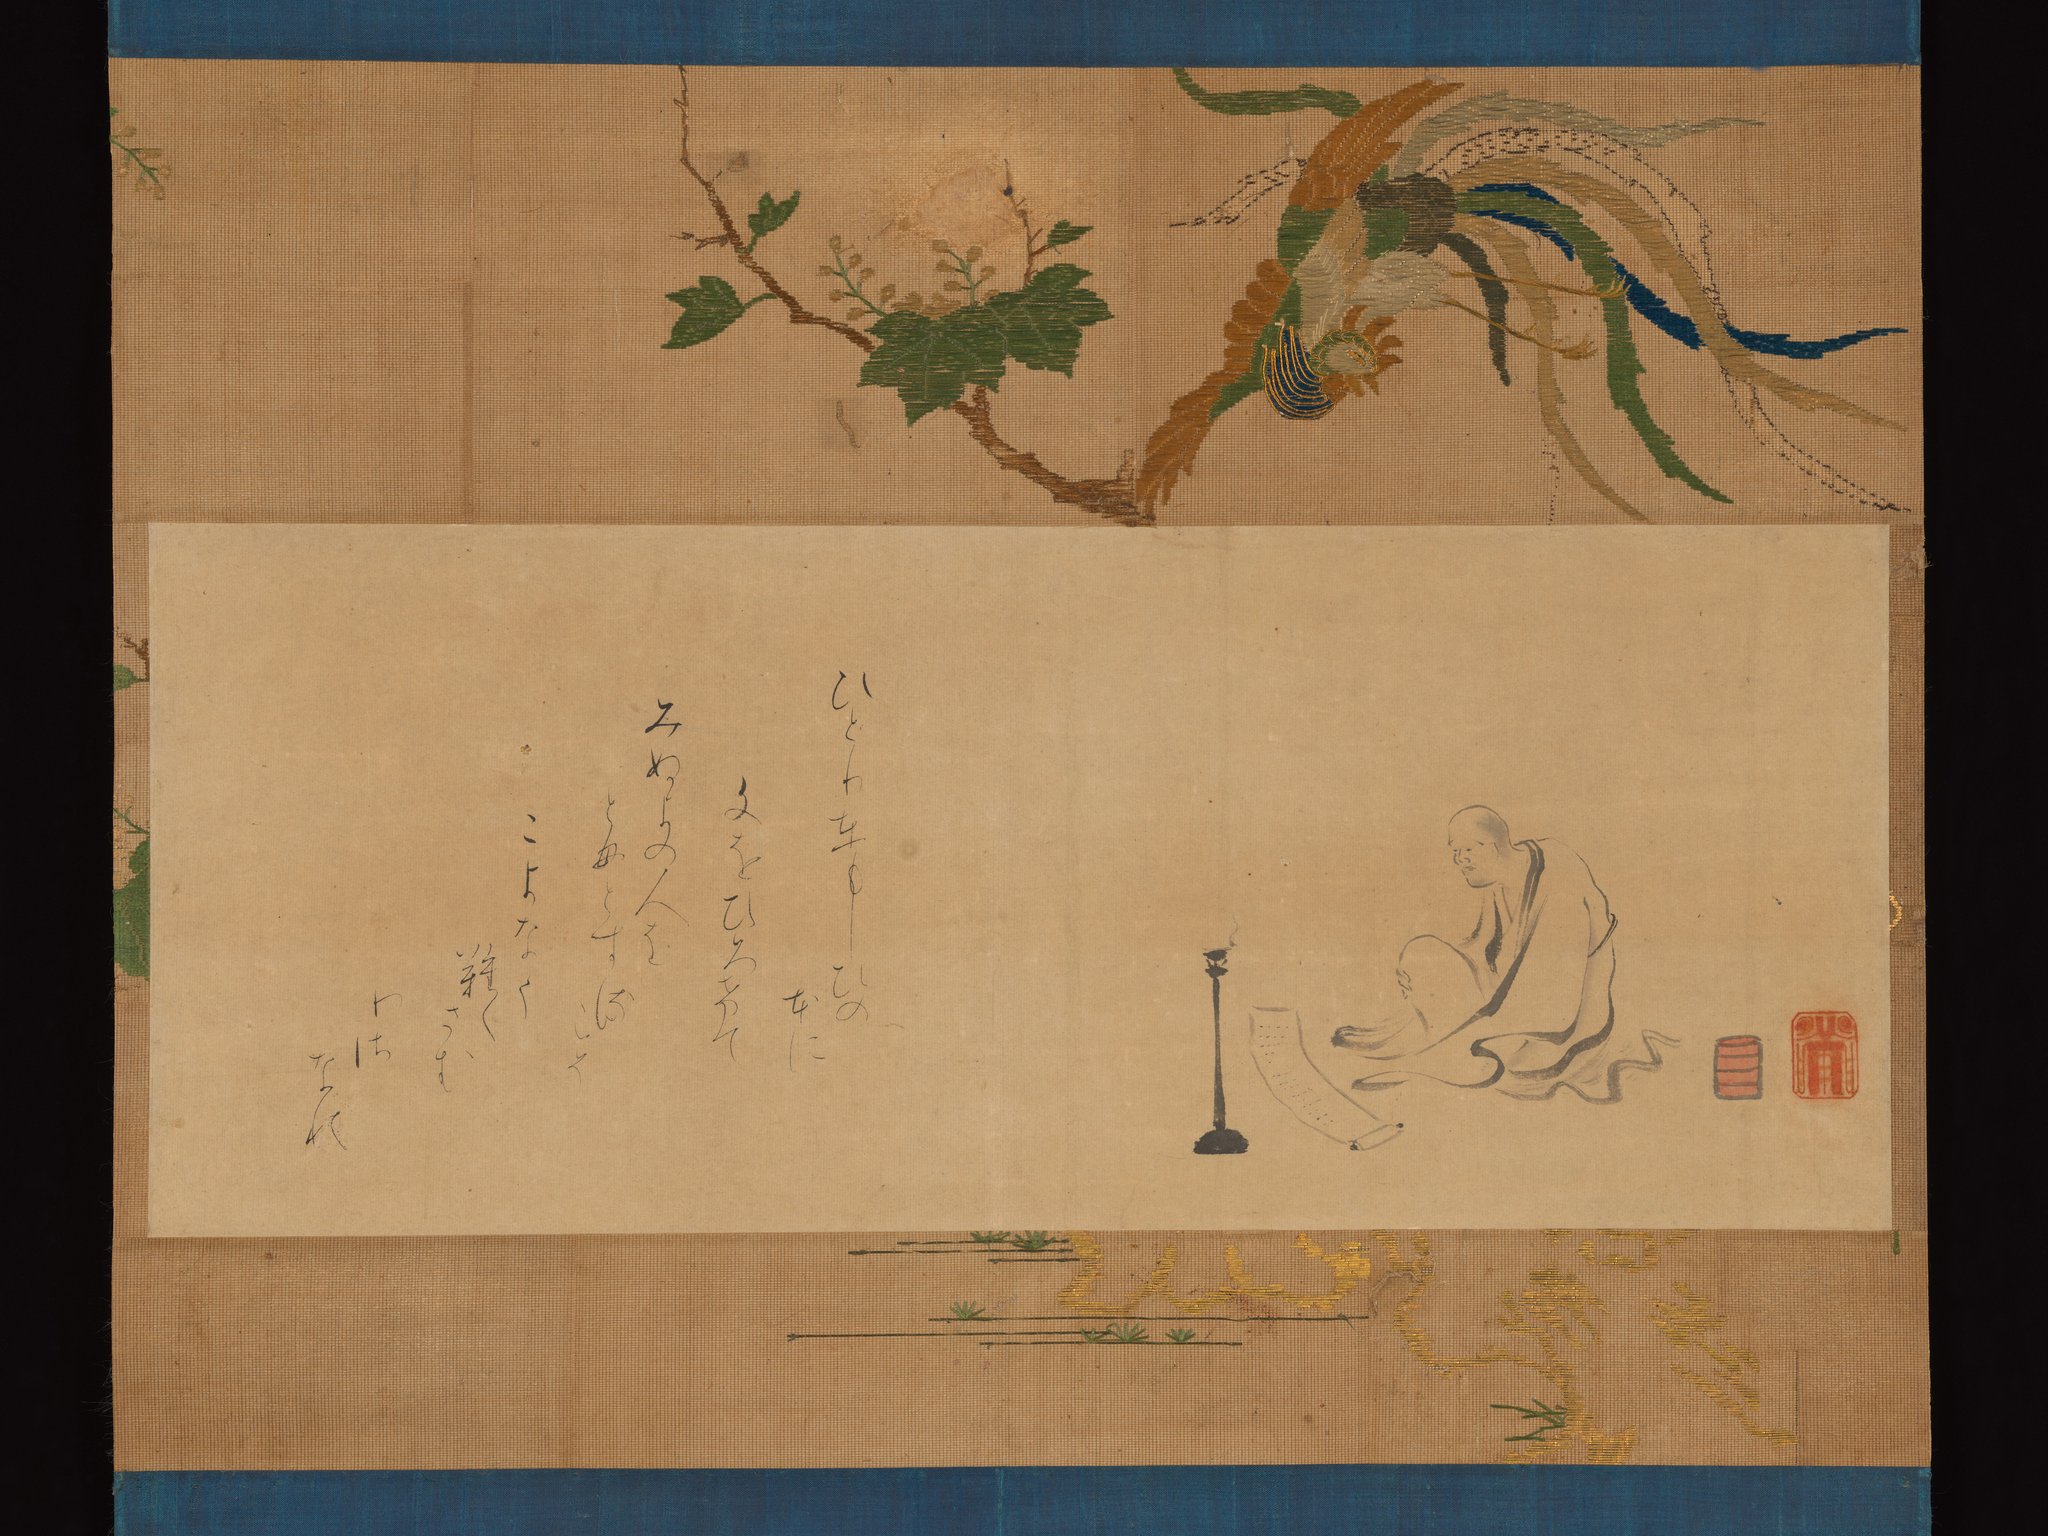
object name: hanging scroll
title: Monk Kenkō Reading by Lamplight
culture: japanese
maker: prince-abbot ryōshō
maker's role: artist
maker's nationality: japanese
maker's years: 1623-1693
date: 1667-1700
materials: ink, paper